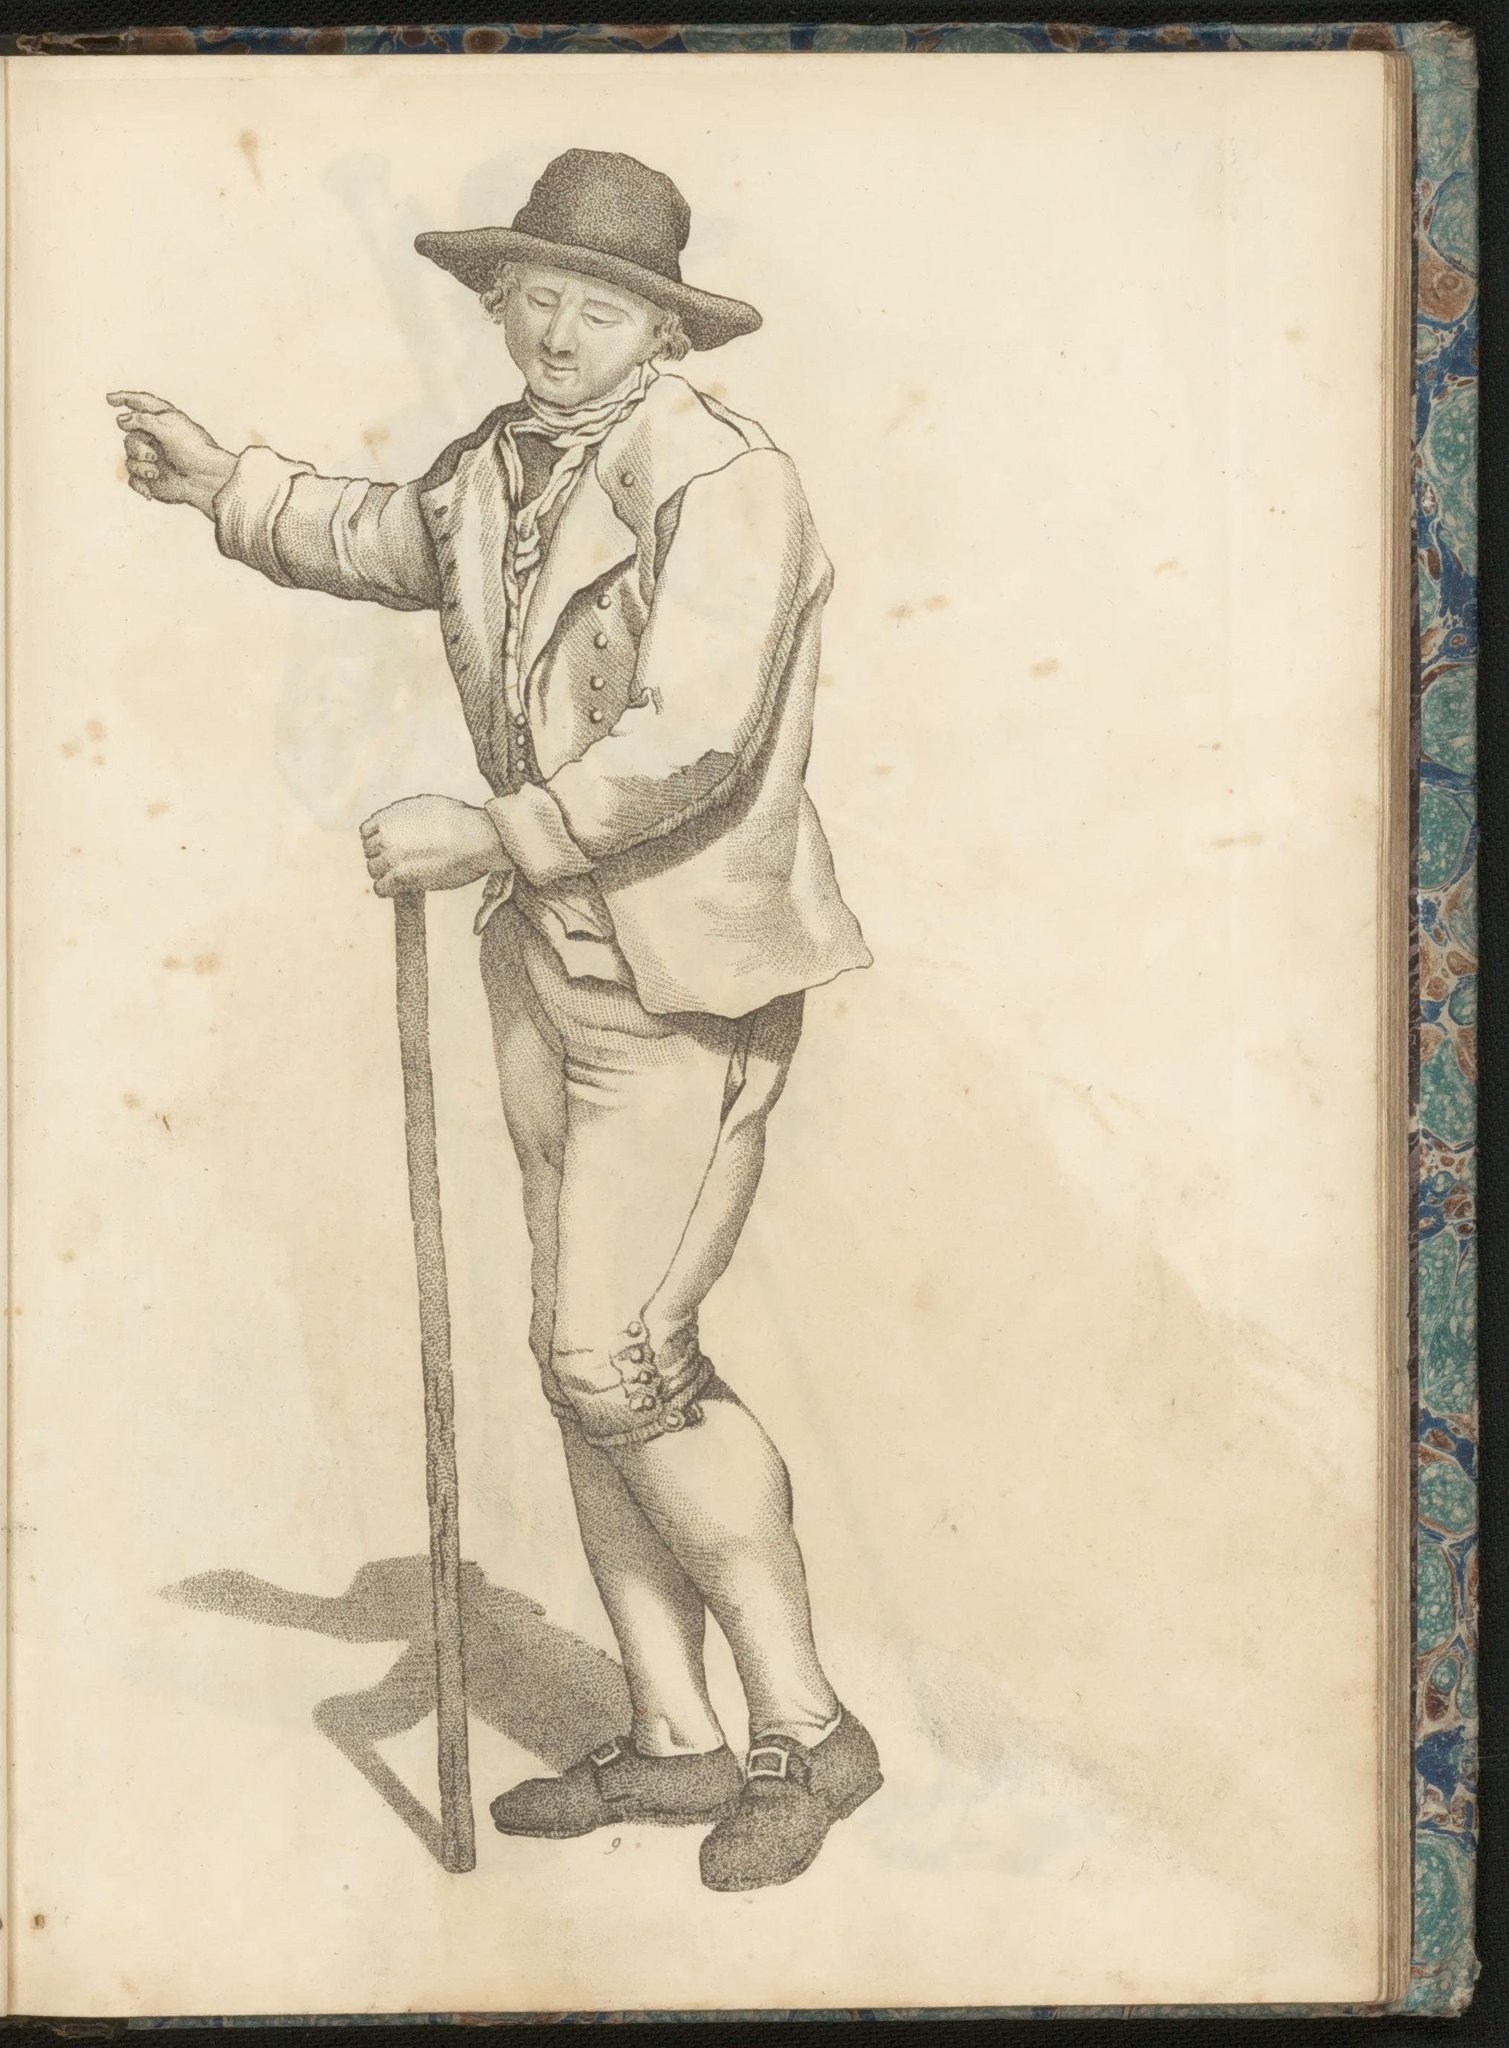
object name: print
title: Man die niet kan zien met wandelstok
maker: mathias de sallieth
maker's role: print maker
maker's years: 1749-1791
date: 1772-1791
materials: paper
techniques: printmaking, etching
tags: folk costume, regional costume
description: De prent verscheen vanaf 1818 tevens als onderdeel van een 33-delige reeks prenten door Mathias de Sallieth, samengebonden in: Perkois, Jacobus, Prins, Johannes Huibert. Verzameling van verschillende gekleede mans- en vrouwenstanden, ter oefening van jonge schilders en liefhebbers. Rotterdam: Johannes Immerzeel, 1818. Alle verso-bladen uit dit prentalbum zijn blanco.